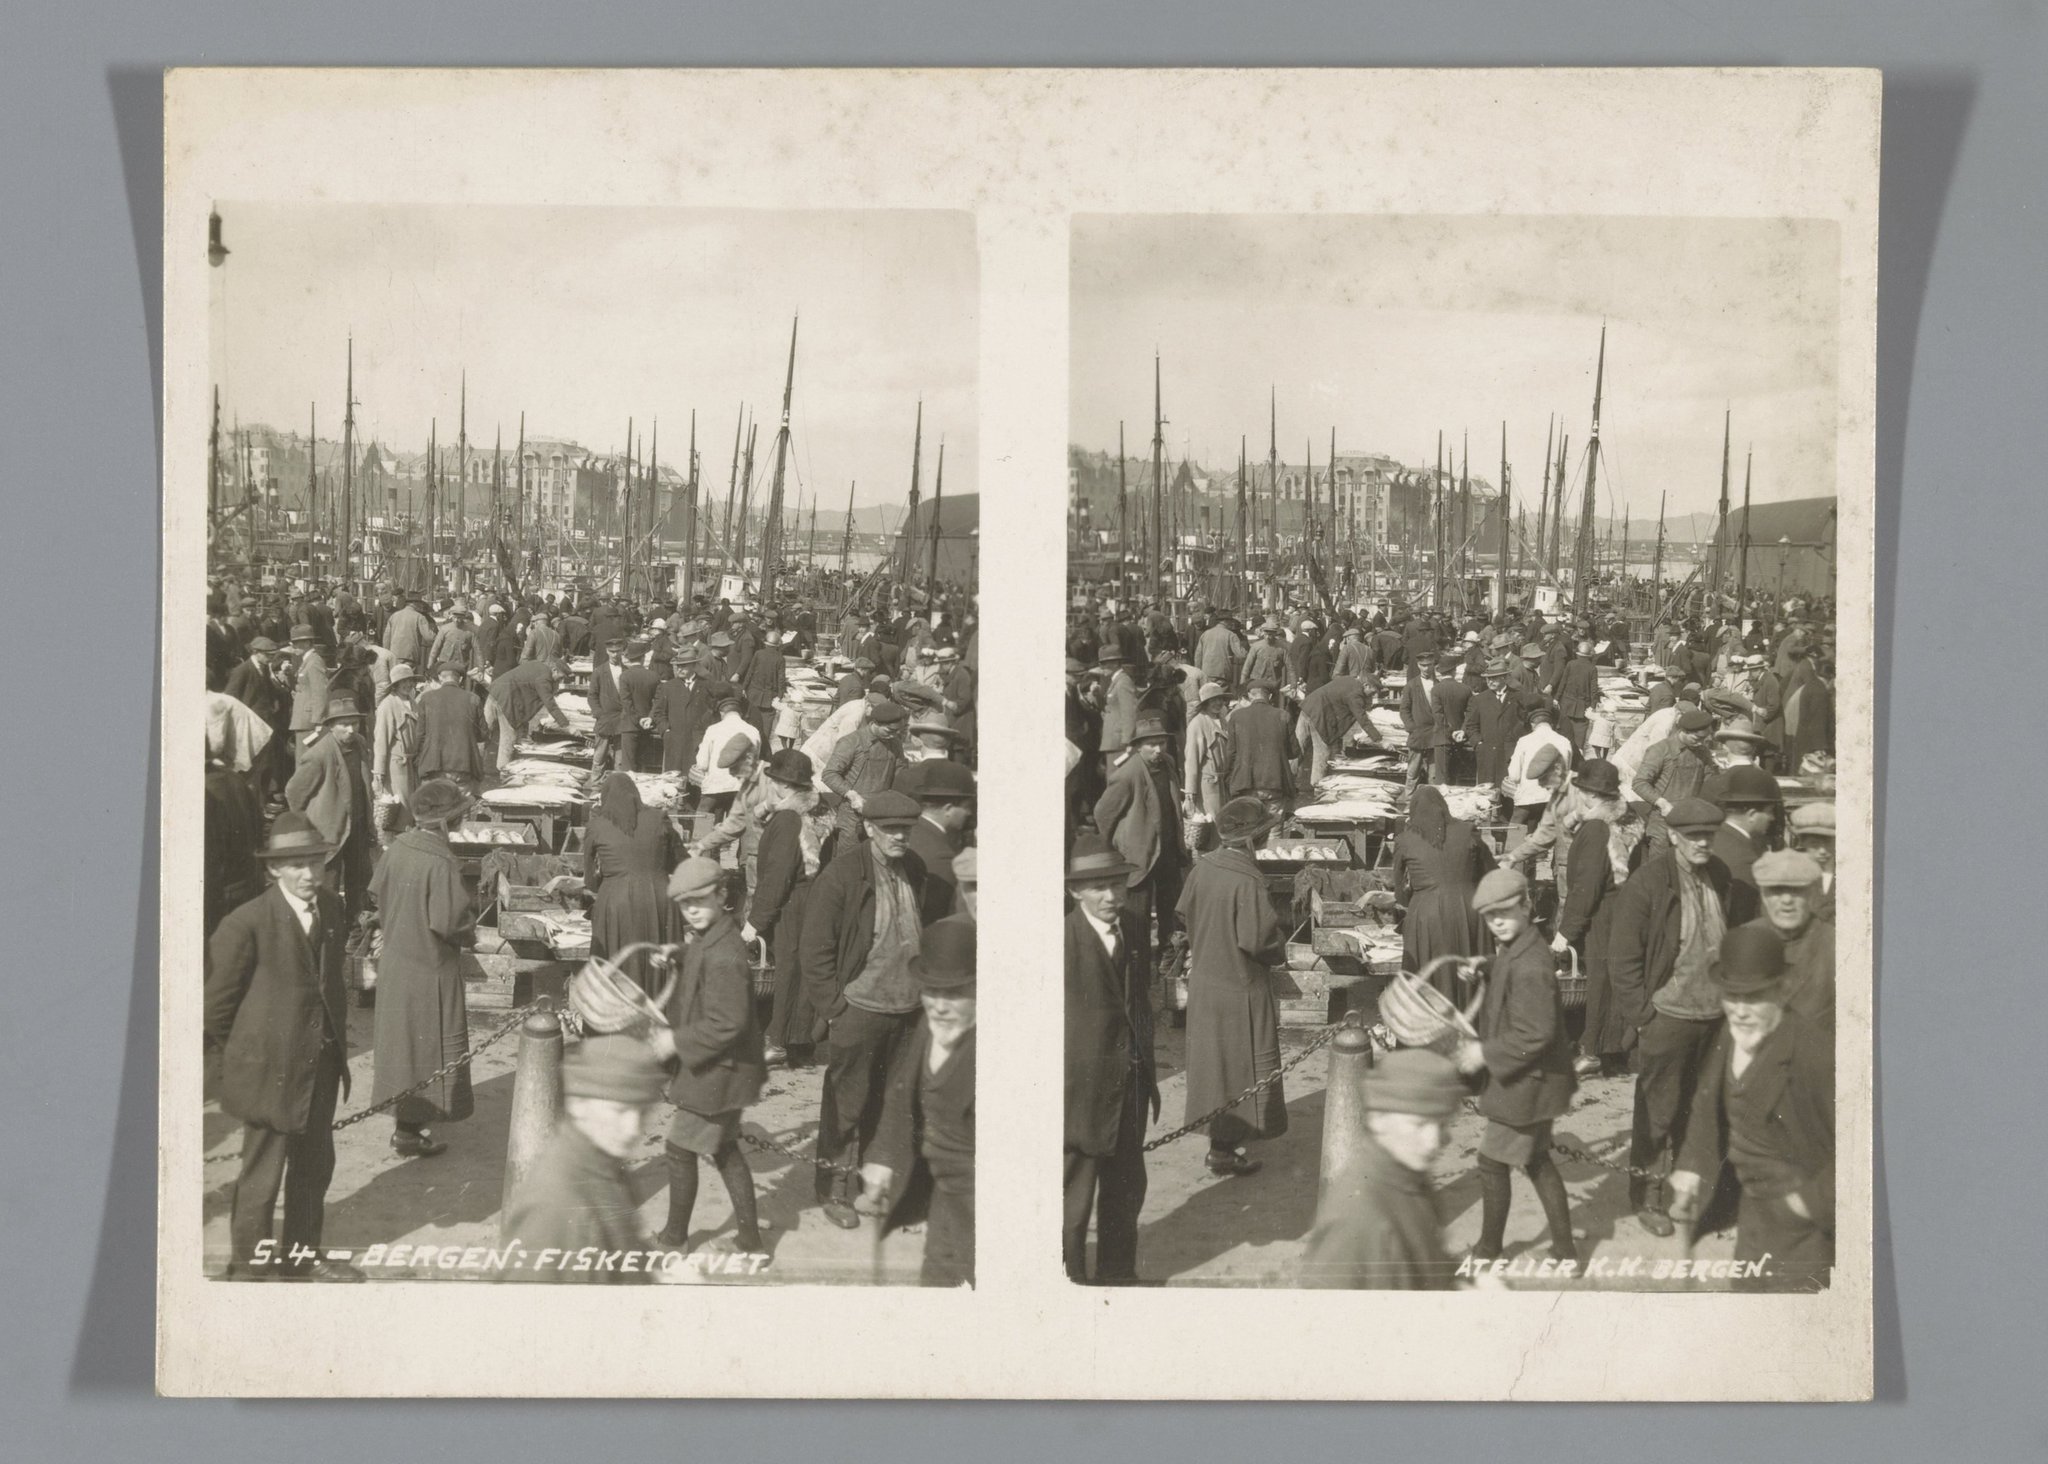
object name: stereograph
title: Bergen: Fisketorvet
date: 1898-1935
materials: paper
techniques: gelatin silver print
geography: bergen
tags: fishes, market, selling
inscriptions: number: ‘5.4.’